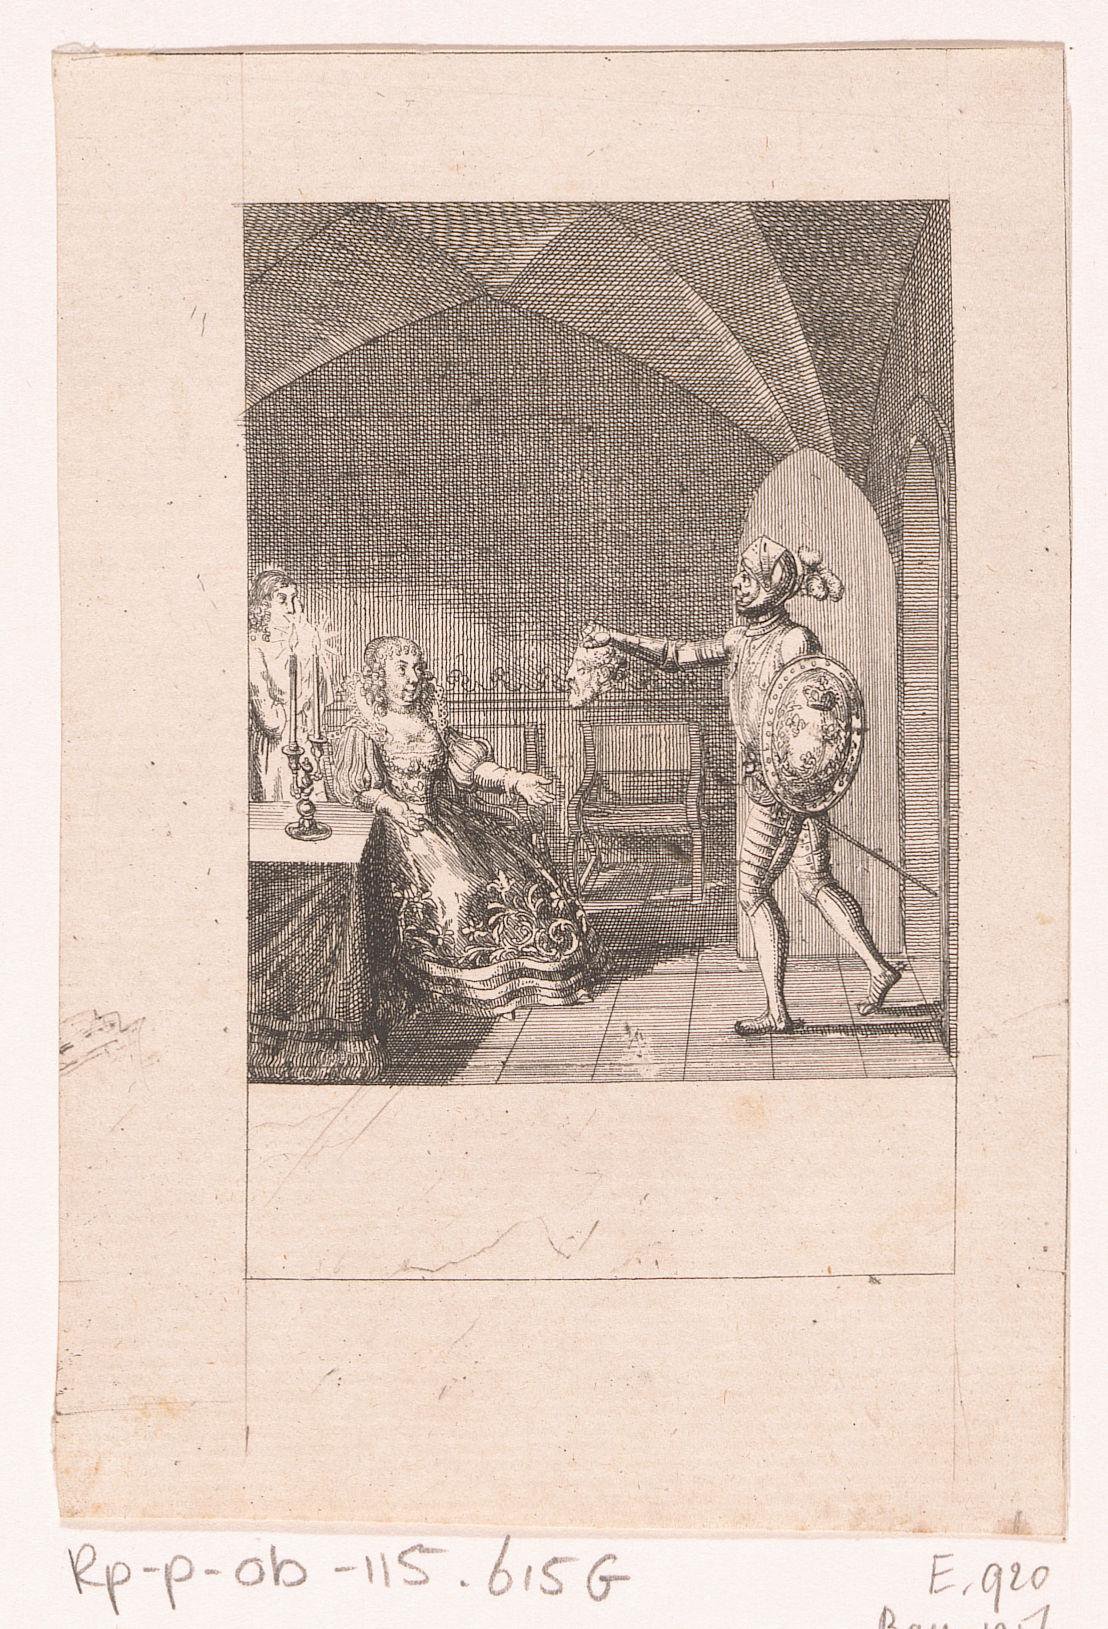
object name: print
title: Catharina de'Medici krijgt het afgehakte hoofd van Coligny te zien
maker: daniel nikolaus chodowiecki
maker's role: draughtsman, print maker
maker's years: 1726-1801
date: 1799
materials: paper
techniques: etching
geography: berlin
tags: paris, politician, gaspard de coligny (ii), head of a beheaded person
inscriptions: collector's mark: Lugt 2228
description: Prent gebruikt voor: Historisch-genealogischer Kalender auf das Jahr 1799 und 1800. Die Geschichte der Bartholomäusnacht oder die Bluthochzeit zu Paris. Berlijn: Johann Friedrich Unger, [1799].